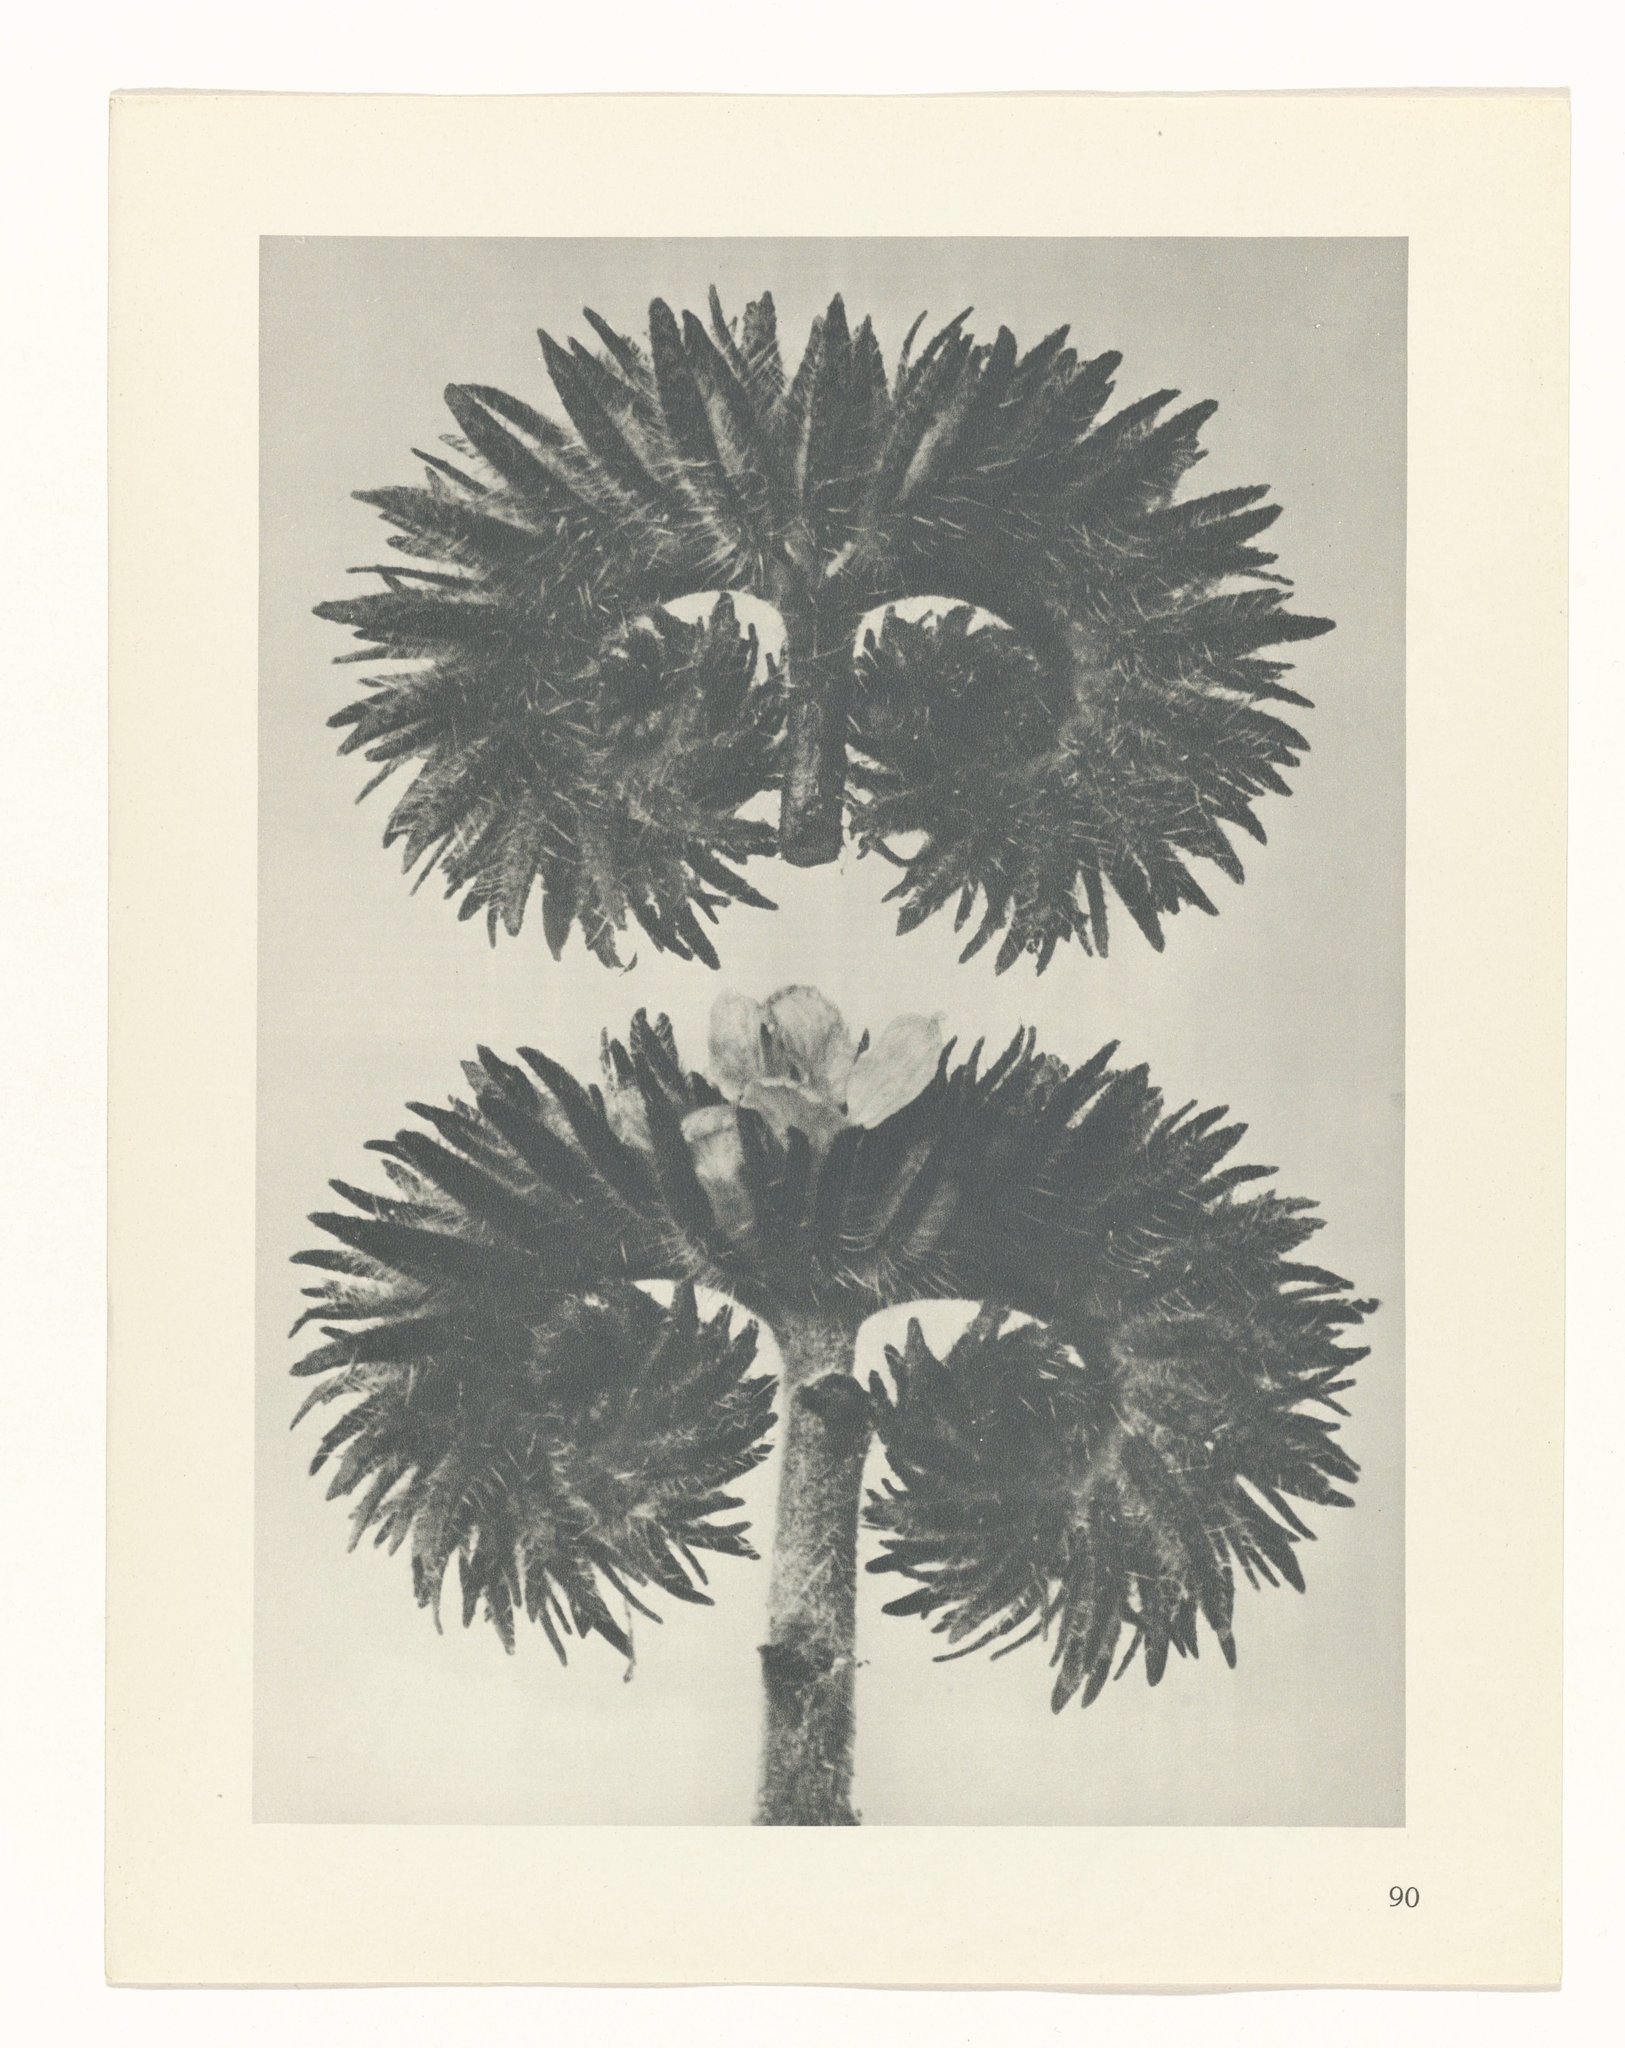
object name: photograph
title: Plantstudie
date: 1928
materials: ink, paper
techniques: rotogravure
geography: berlin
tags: plants (in general)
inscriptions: number: ‘90’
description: facher Vergrößerung. Afkomstig uit losbladige uitgave.